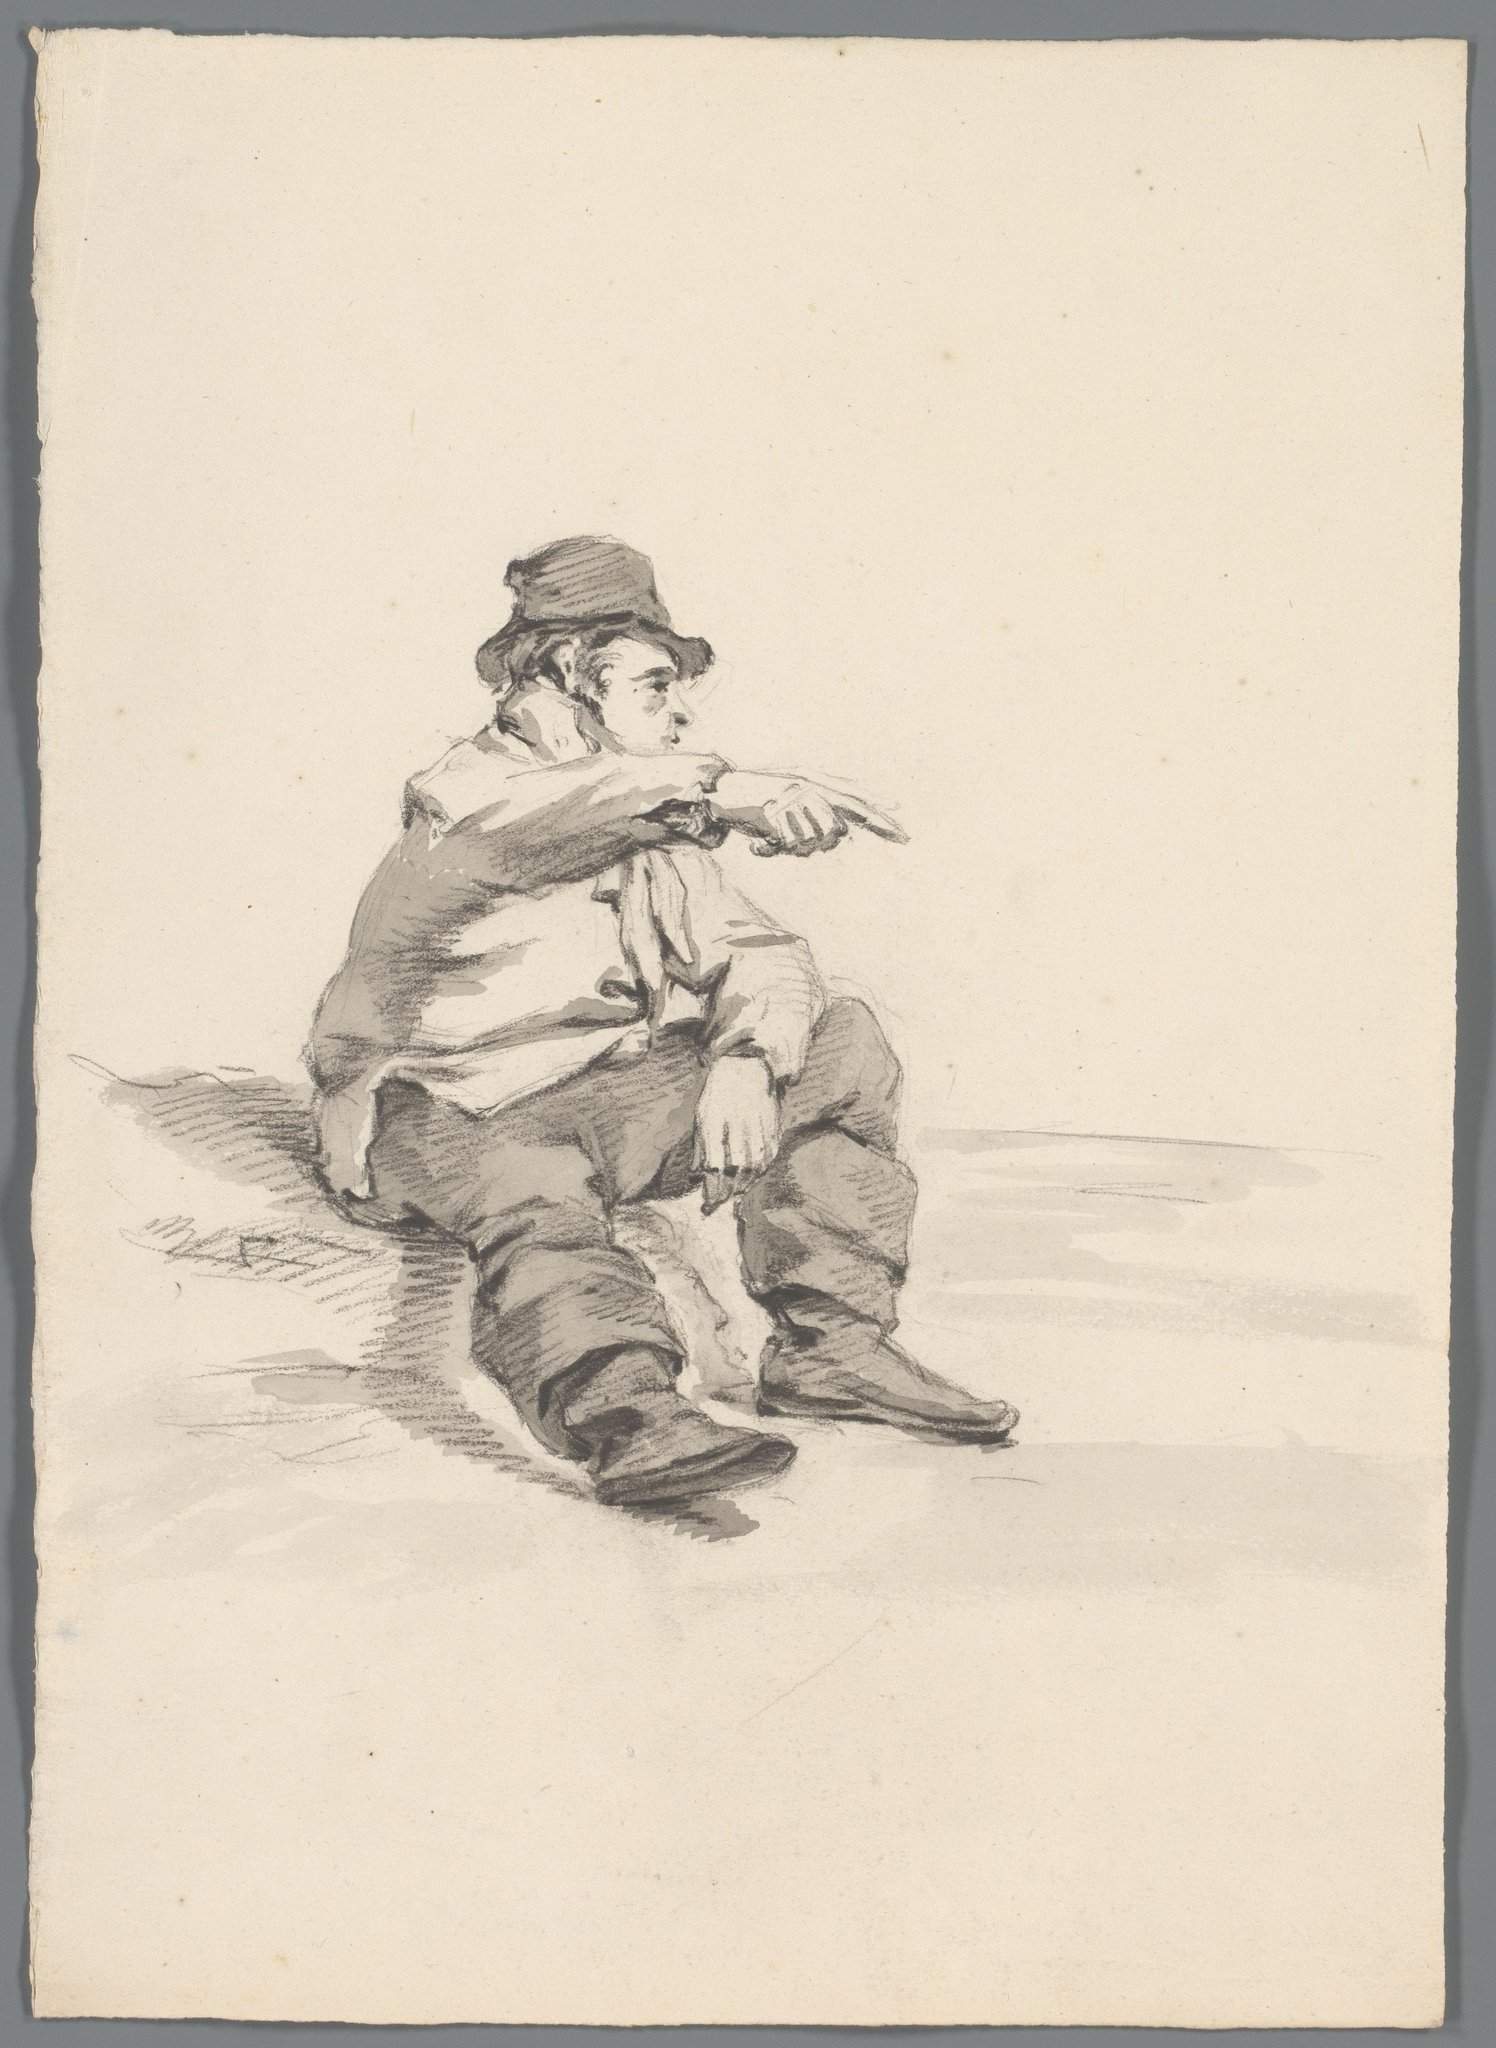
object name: drawing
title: Zittende man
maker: Anonymous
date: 1820-1830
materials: chalk, paper, watercolor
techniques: brush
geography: the hague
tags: sitting figure, adult man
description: Tekeningen waarschijnlijk ontstaan bij het Haagse kunstgenootschap ‘Tot Nut der Tekenkunst’, waar twee keer per week tekenavonden werden georganiseerd met geklede modellen.